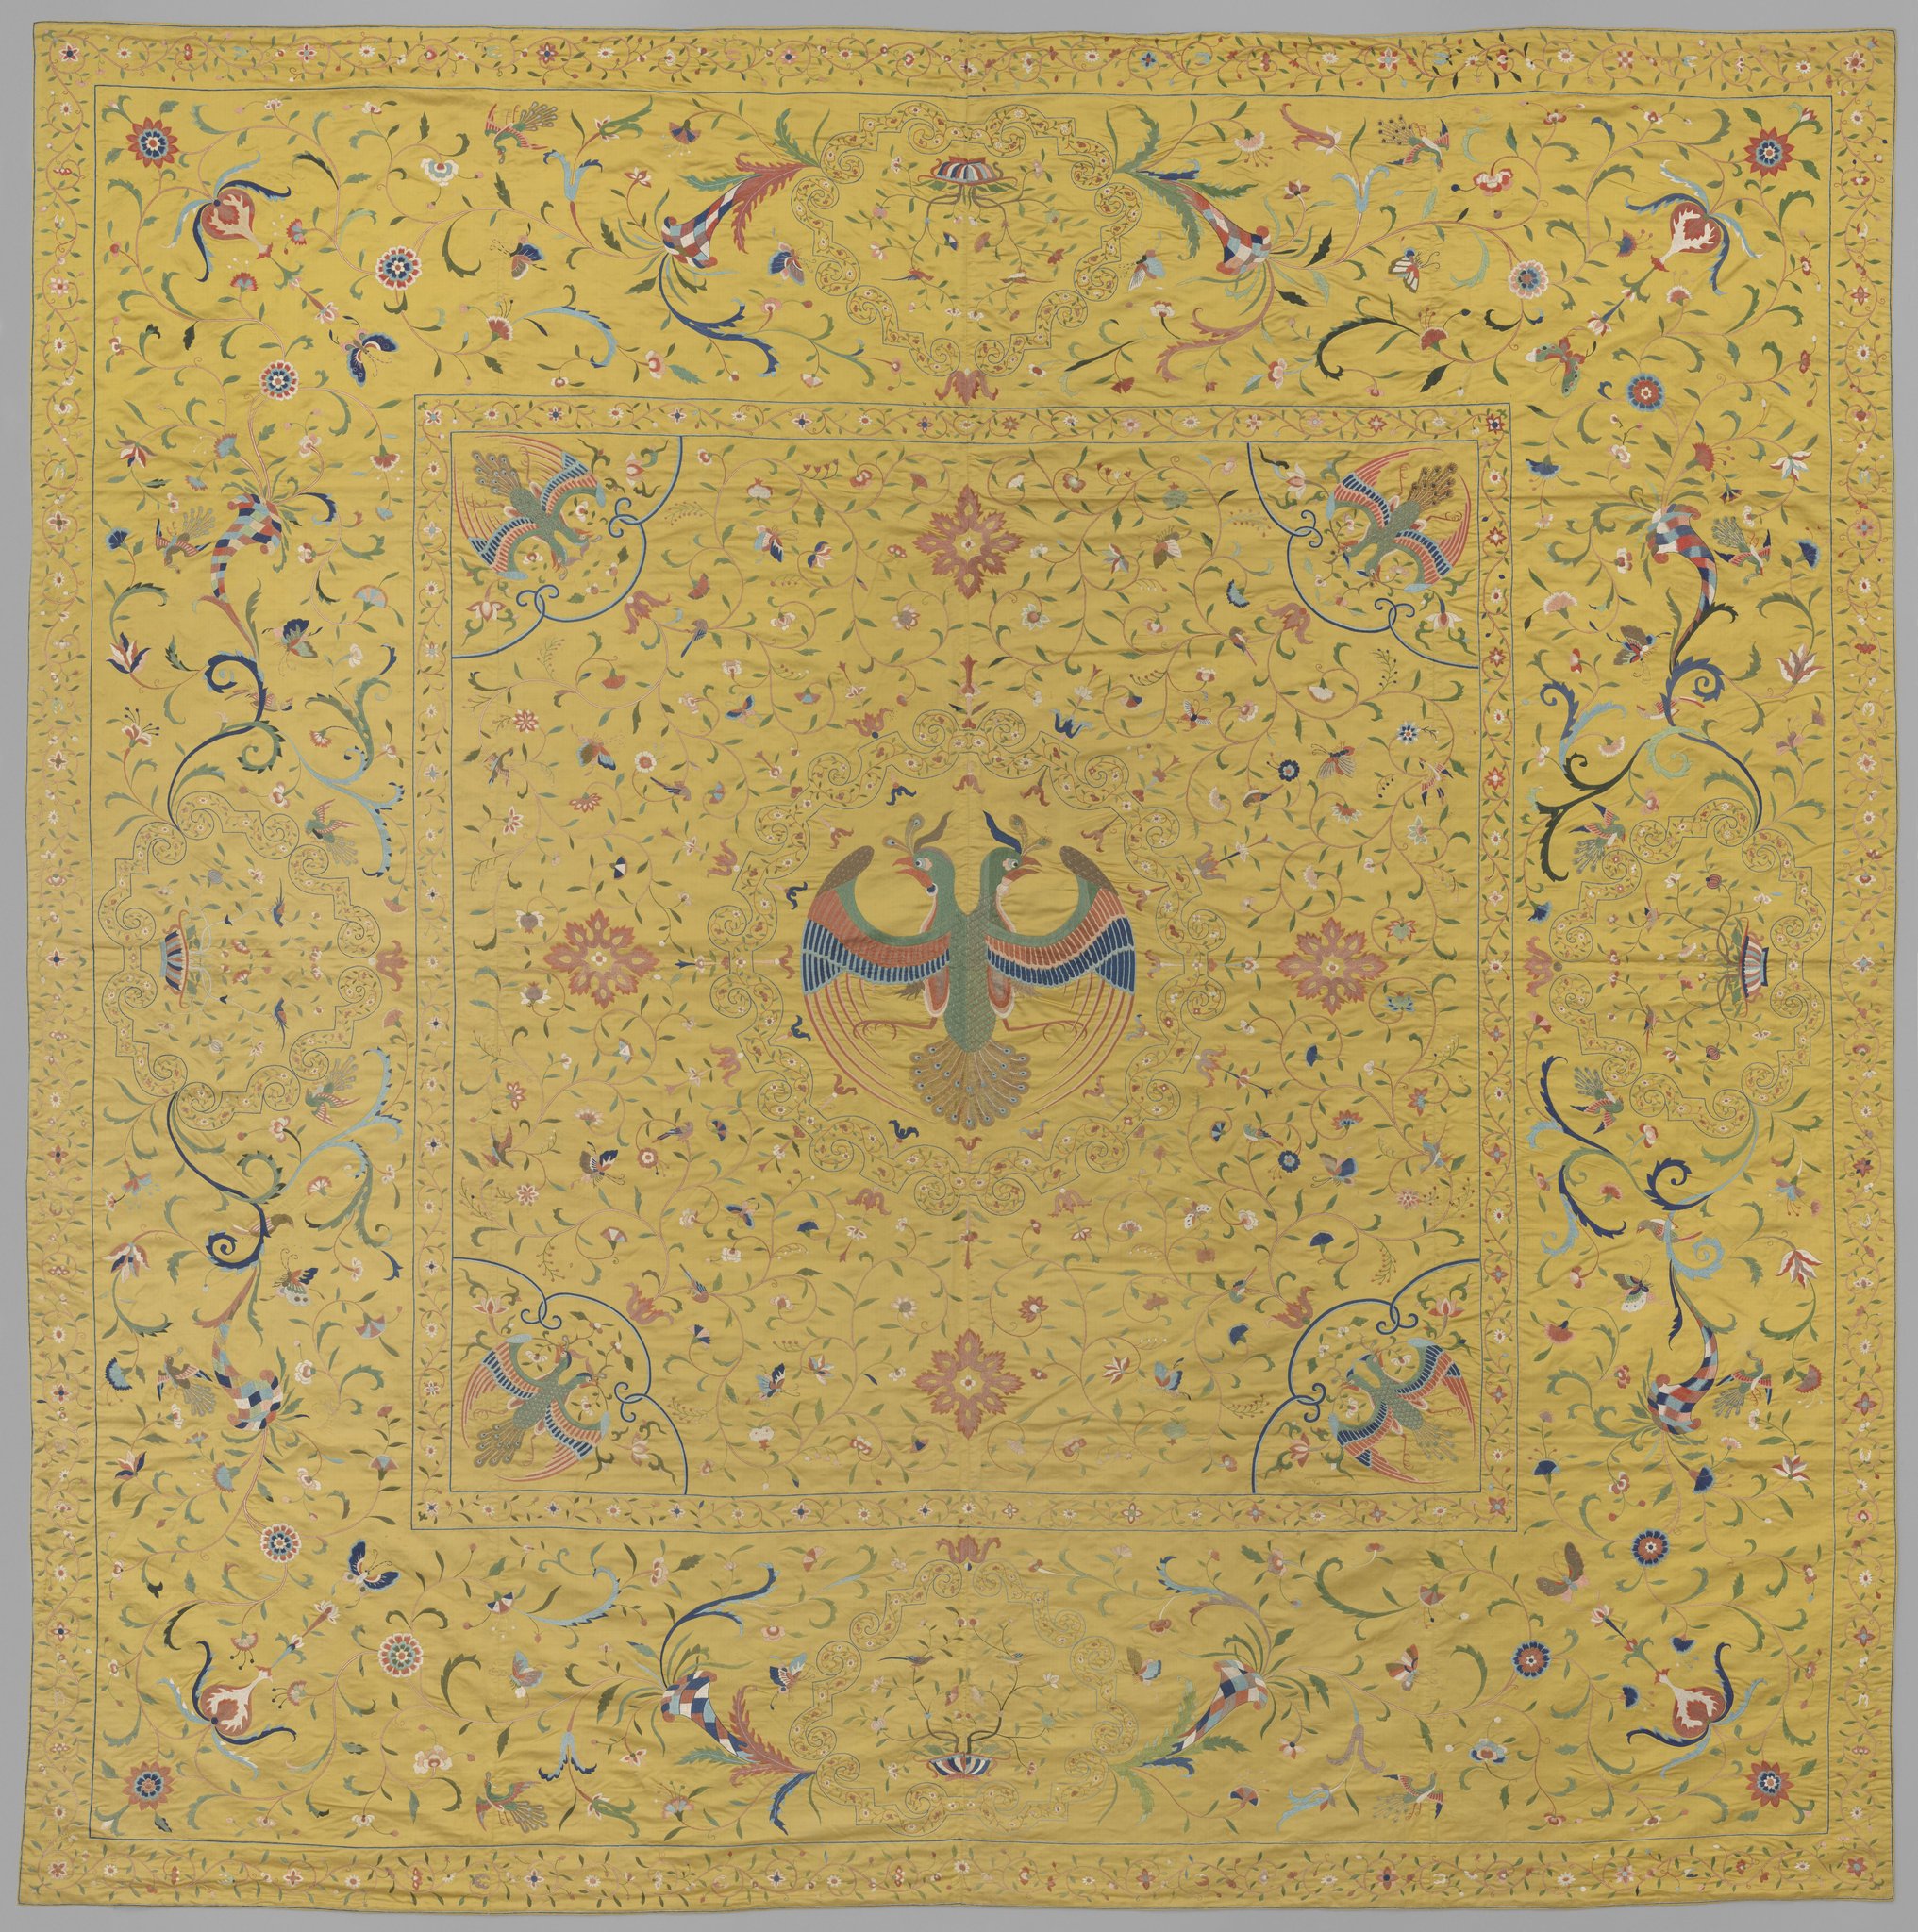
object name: bedspread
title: Sprei met dubbelkoppige pauwen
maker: Anonymous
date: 1750-1770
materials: linen, silk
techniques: embroidered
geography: china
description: Geel zijden beddensprei met geborduurde dubbelkoppige pauwen, vlinders, granaatappels en bloemranken in veelkleurige zijde, gevoerd met grof linnen.